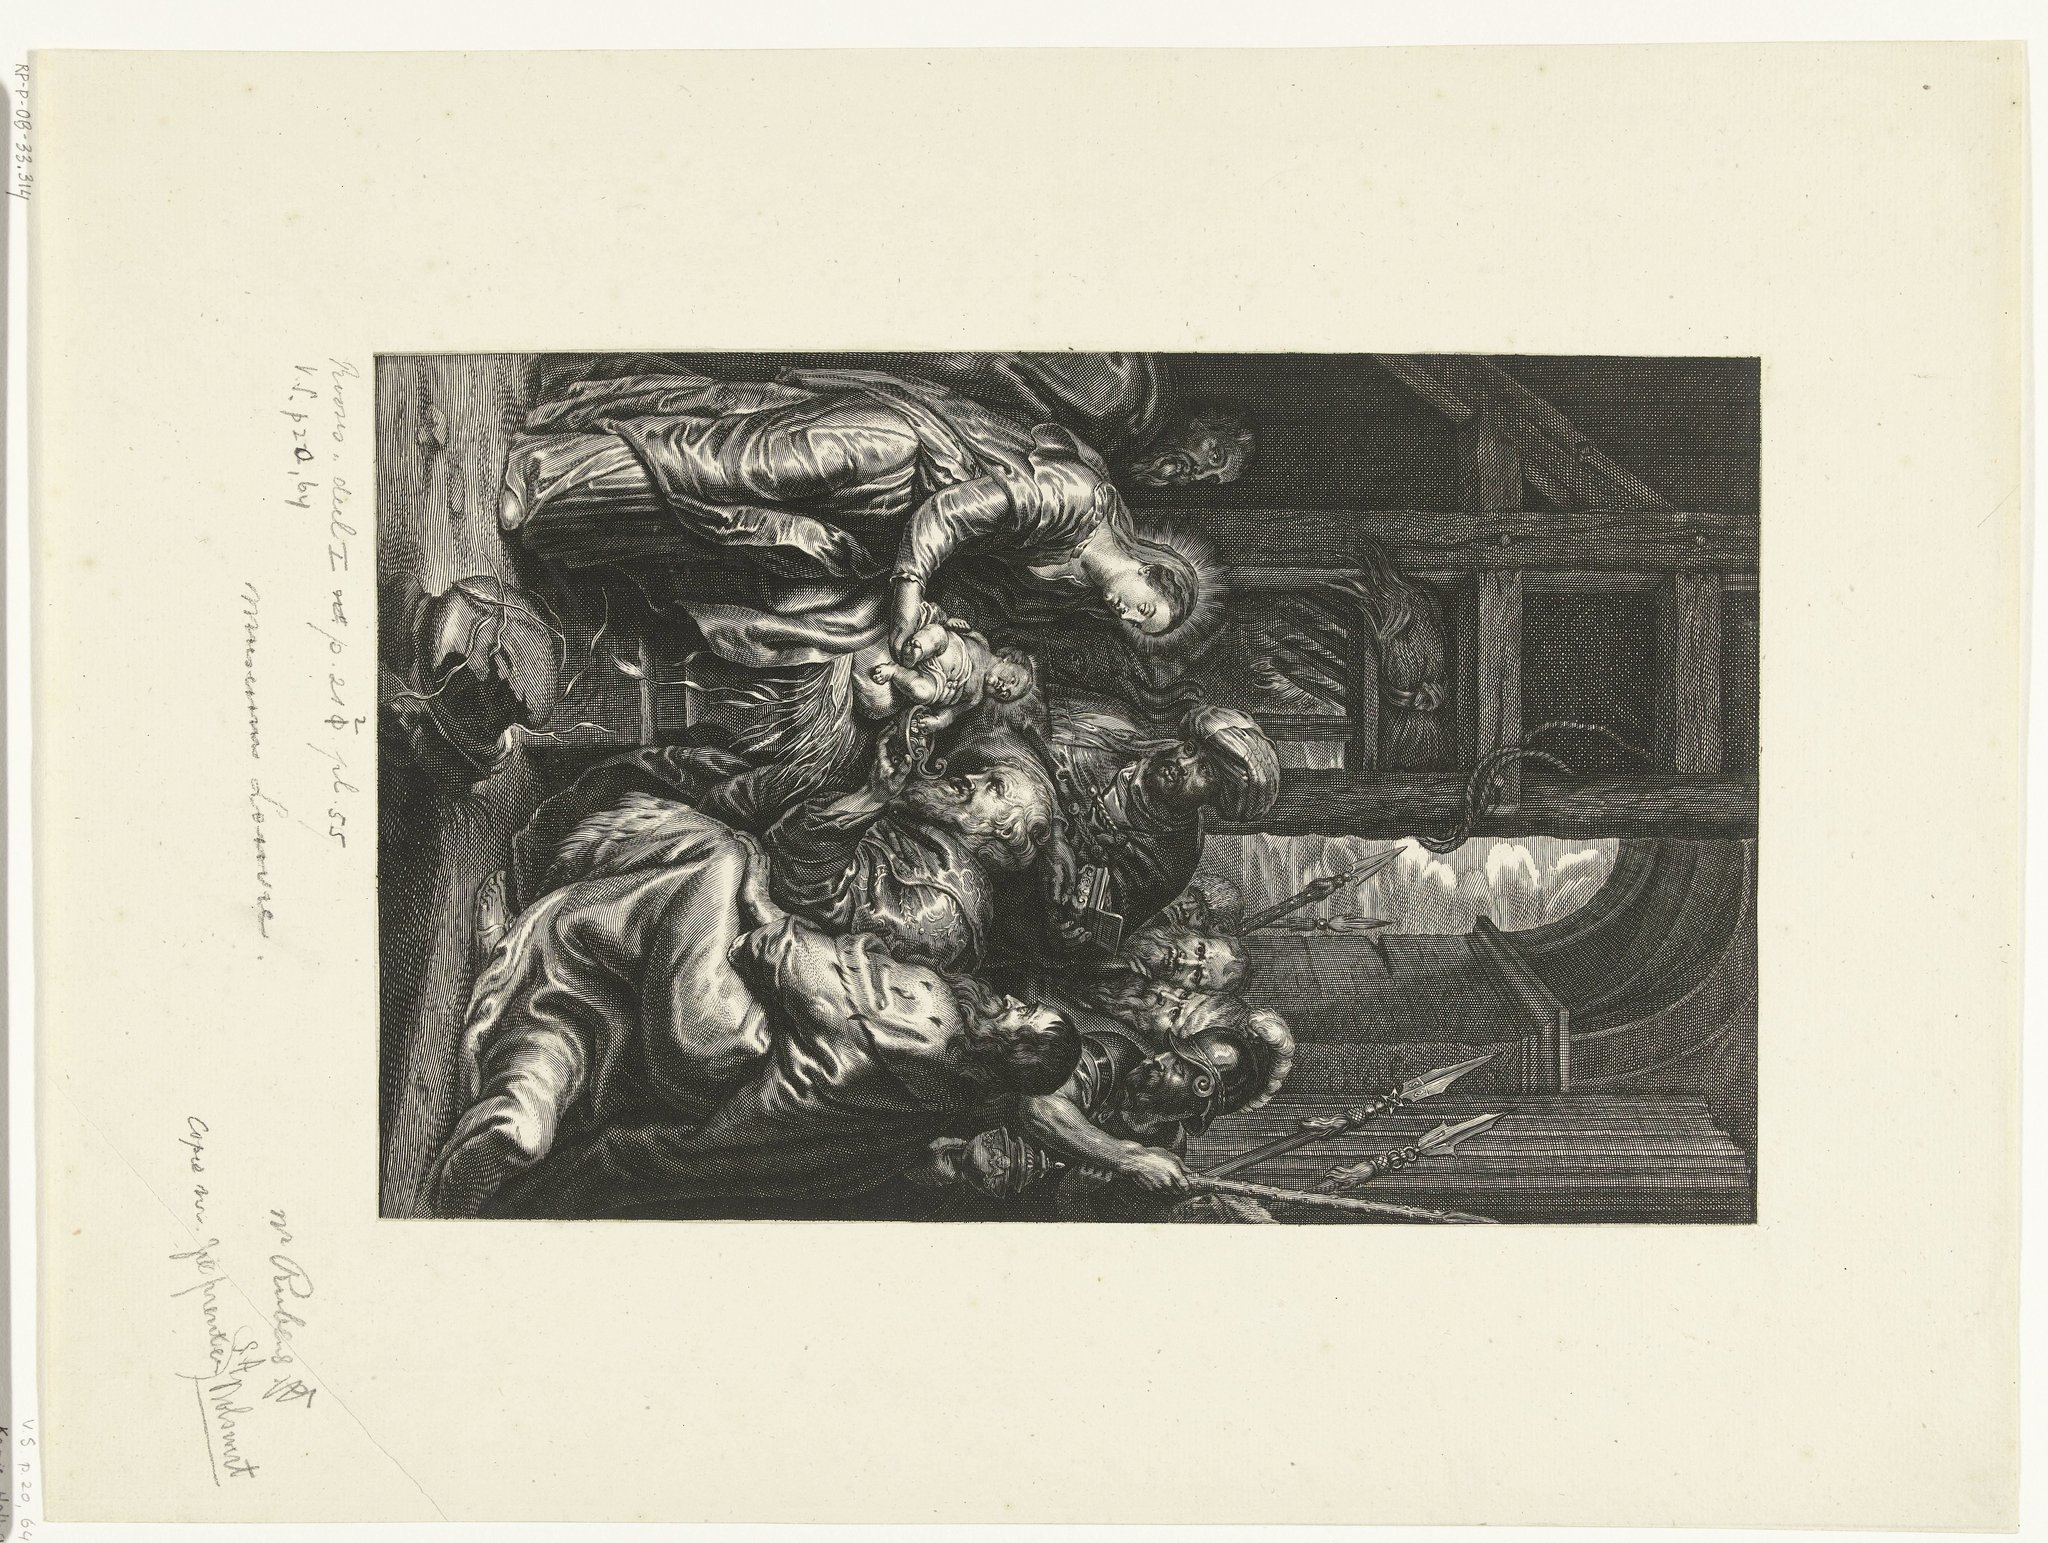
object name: print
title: Aanbidding van het Christuskind door de drie koningen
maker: françois stuerhelt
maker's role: print maker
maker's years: -1652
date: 1596-1659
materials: paper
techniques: engraving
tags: adoration of the kings: the wise men present their gifts to the christ-child (gold, frankincense and myrrh)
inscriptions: collector's mark: Lugt 240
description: Kopie in spiegelbeeld en op kleiner formaat naar prent van Schelte Adamsz. Bolswert. Bolswert vervaardigde zijn prent naar het schilderij van Peter Paul Rubens.